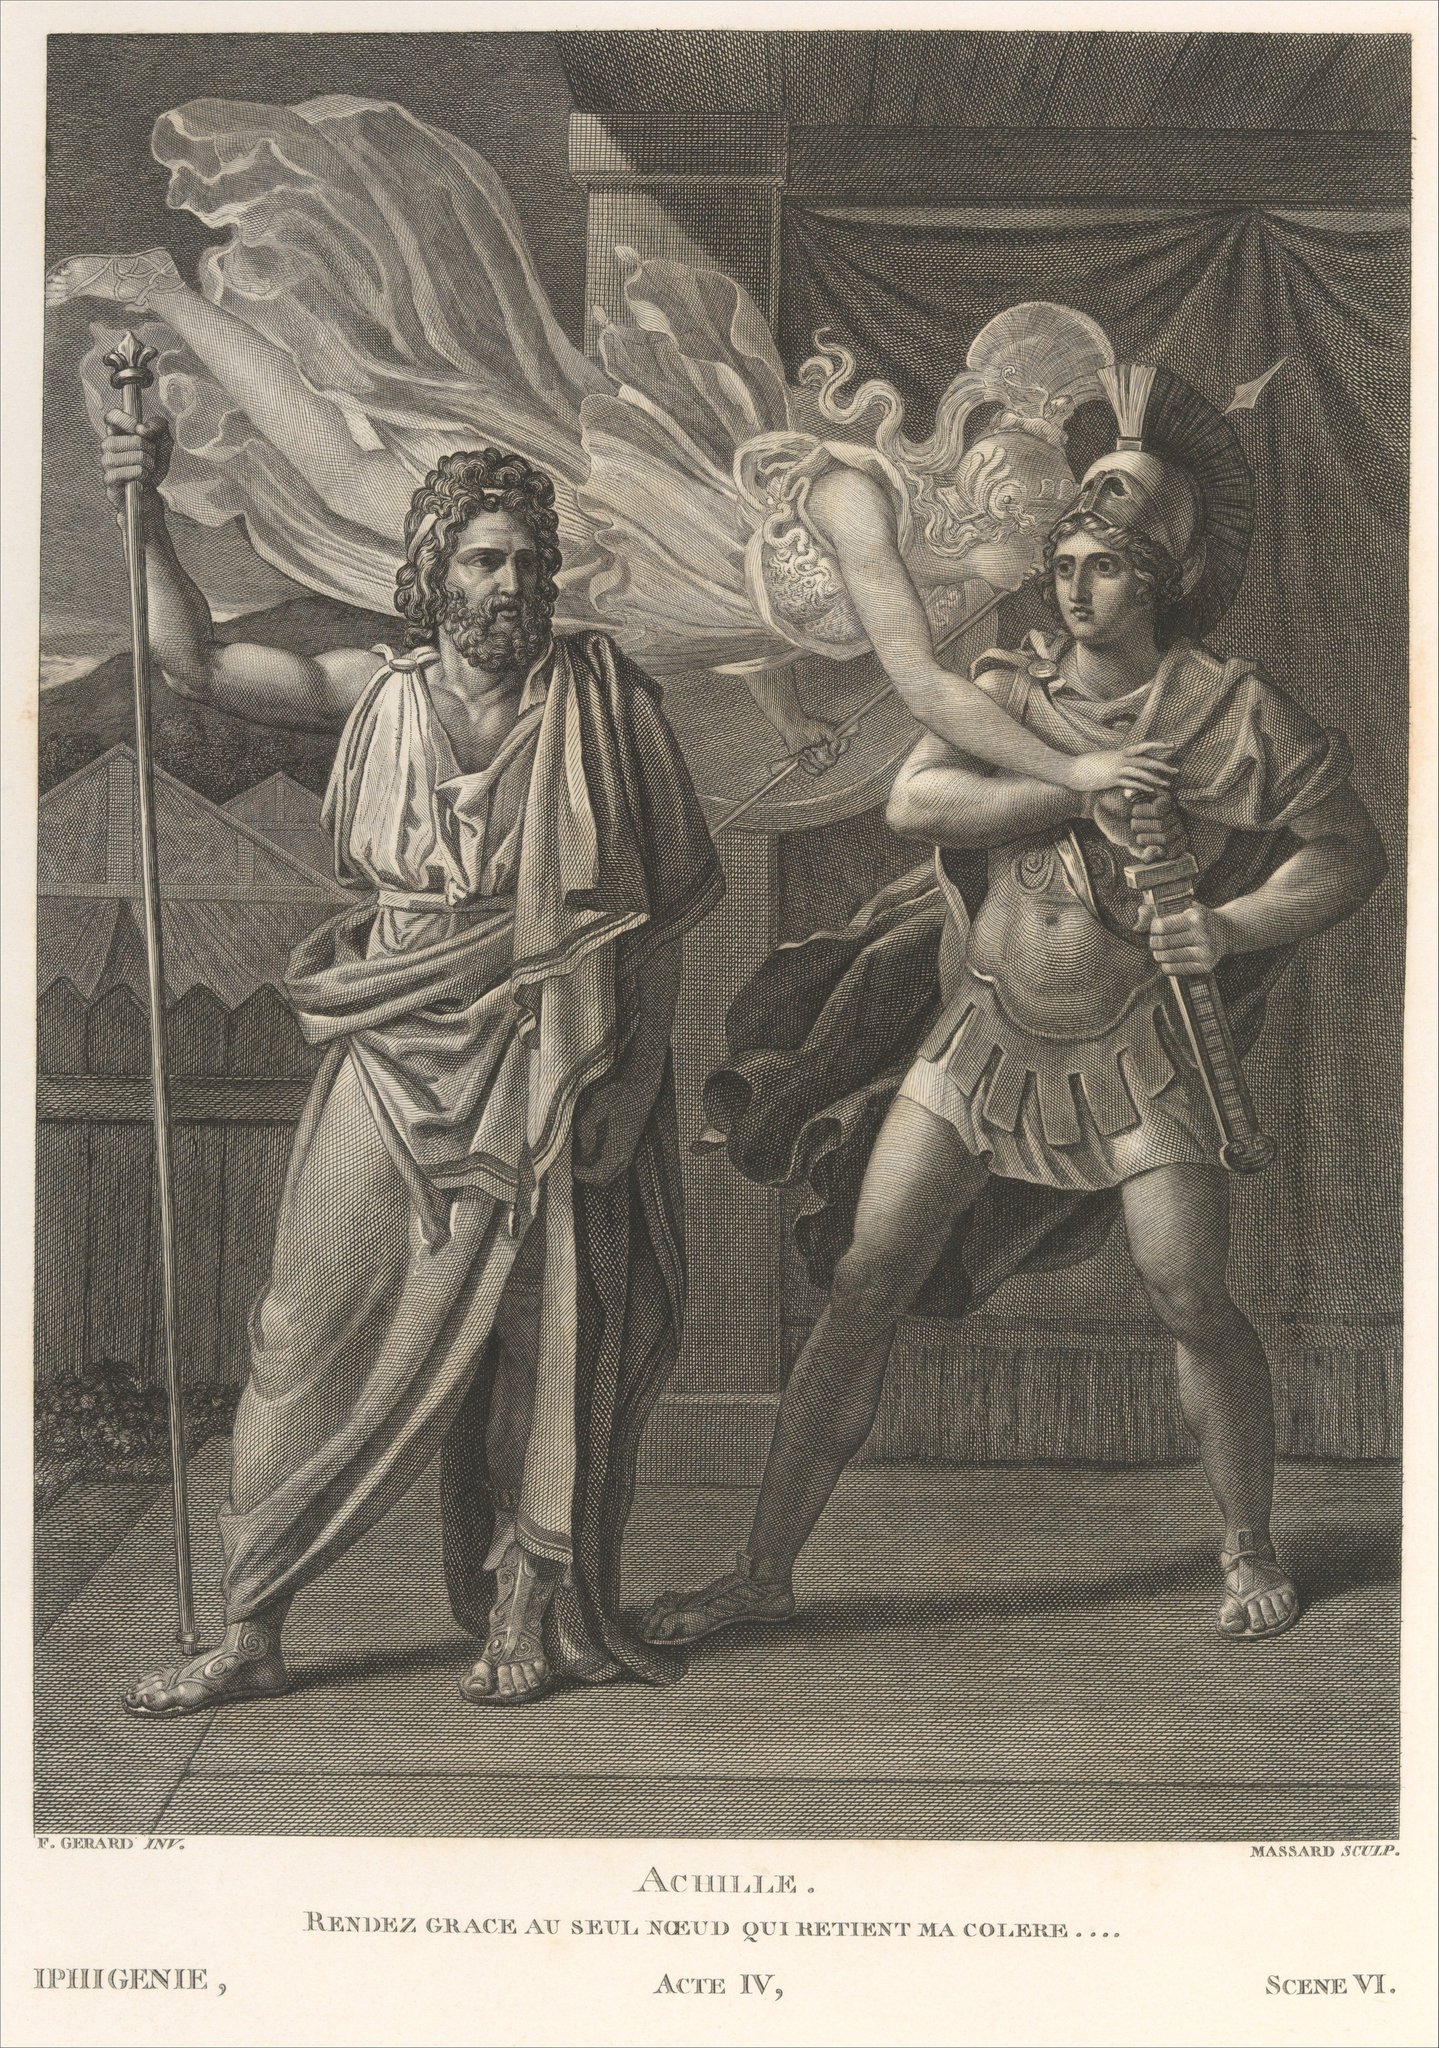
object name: book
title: Oeuvres de Jean Racine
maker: jean racine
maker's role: author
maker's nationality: french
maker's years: 1639-1699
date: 1801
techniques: engraving, printing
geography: france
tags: men,women